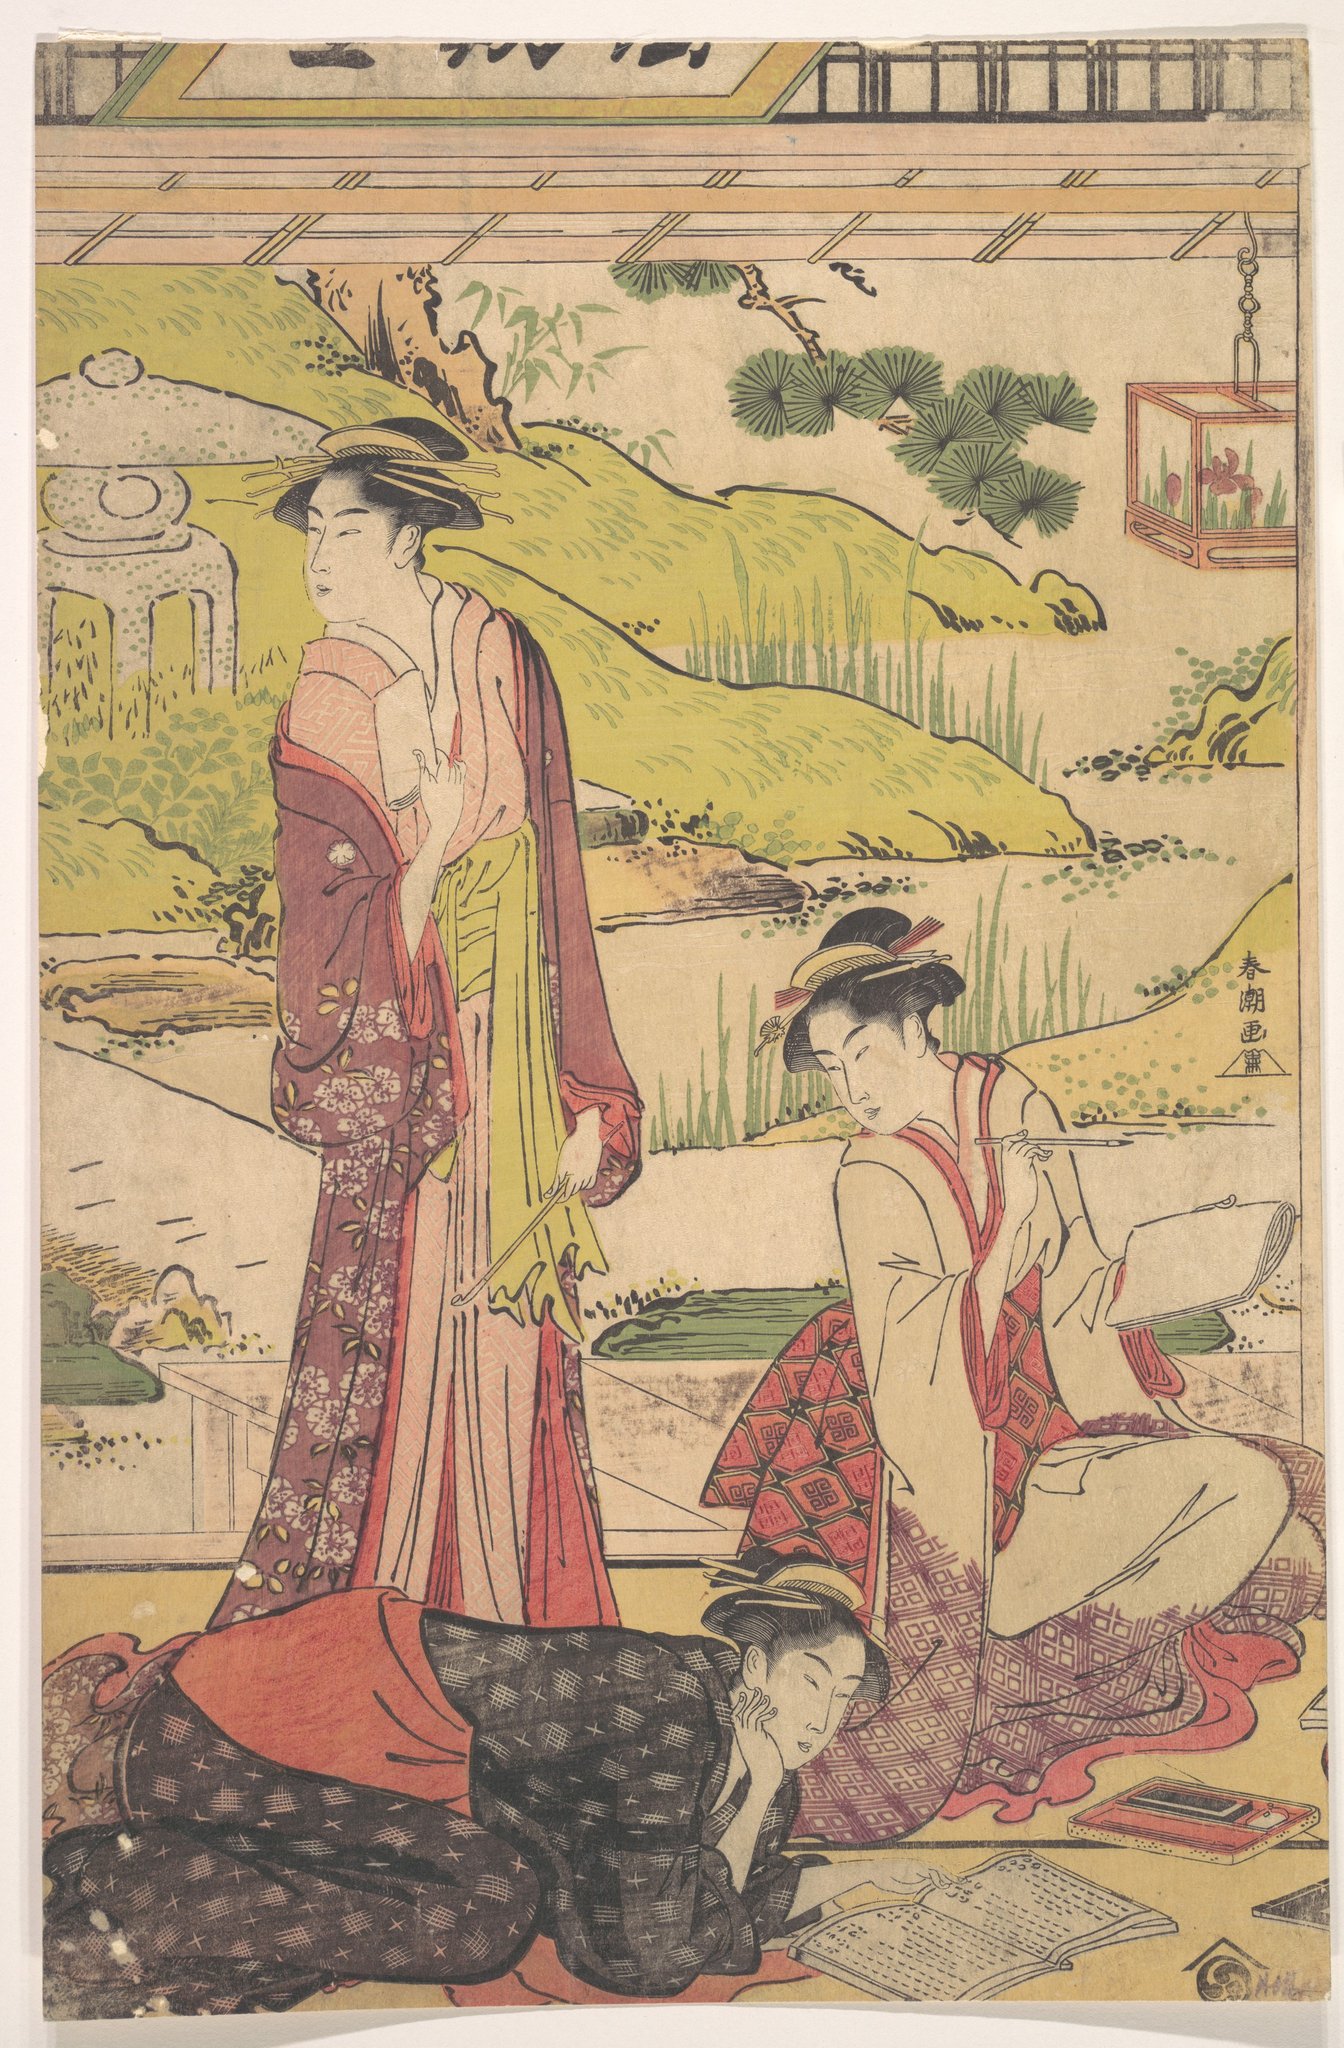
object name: print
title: Three Women Enjoying Literary Pursuits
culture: japanese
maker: katsukawa shunchō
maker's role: artist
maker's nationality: japanese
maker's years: 1775-1795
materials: ink, paper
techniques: woodblock print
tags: women,reading